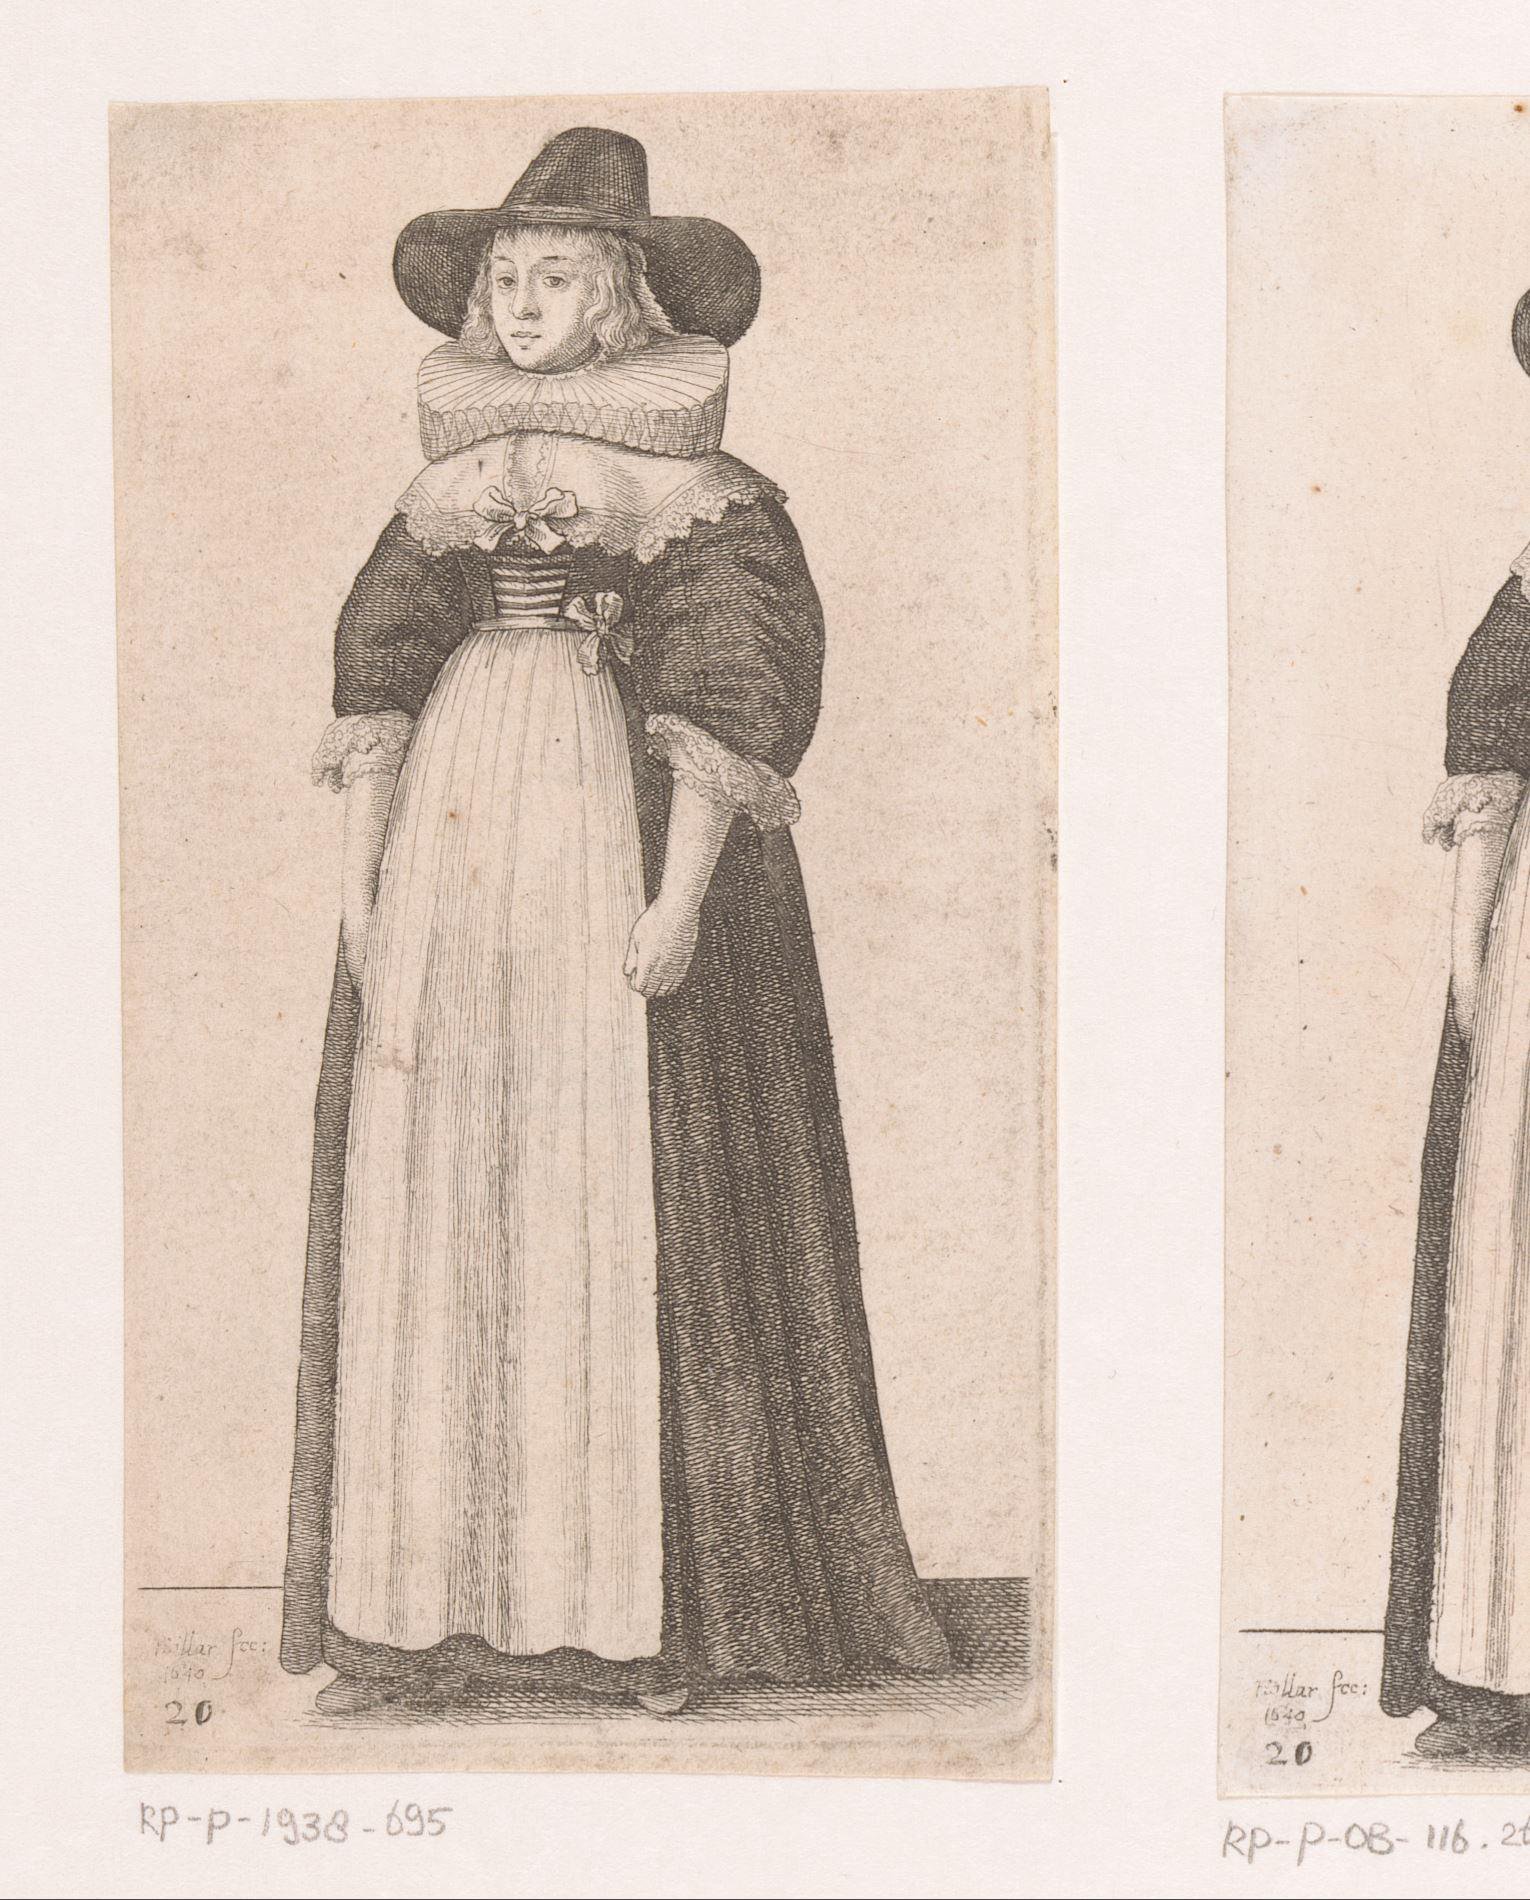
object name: costume print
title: Ornatus Muliebris Anglicanus / The Severall Habits of English Women, from the Nobilitie to the contry woman, they are in these times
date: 1640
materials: paper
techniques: etching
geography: london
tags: bow (ornamental part of clothing) (+ women's clothes), europeans: englishmen (+ women), fashion, clothing (+ lace used for clothes), neck-gear: collar (+ women's clothes), fashion plates, clothes, costume (+ women's clothes), head-gear: hat (+ women's clothes), neck-gear ~ clothing (with name) (+ women's clothes), apron (+ women's clothes)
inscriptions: collector's mark: Lugt 2228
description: Engelse vrouw met een hoed met taps toelopende rechte bol, hoedband en brede rand. Brede dikke plooikraag om de hals. Onder de plooikraag een halsdoek afgezet met kant, in het midden bijeengehouden door een strik. Over de donkere japon een lang wit schort met in de taille een strik.